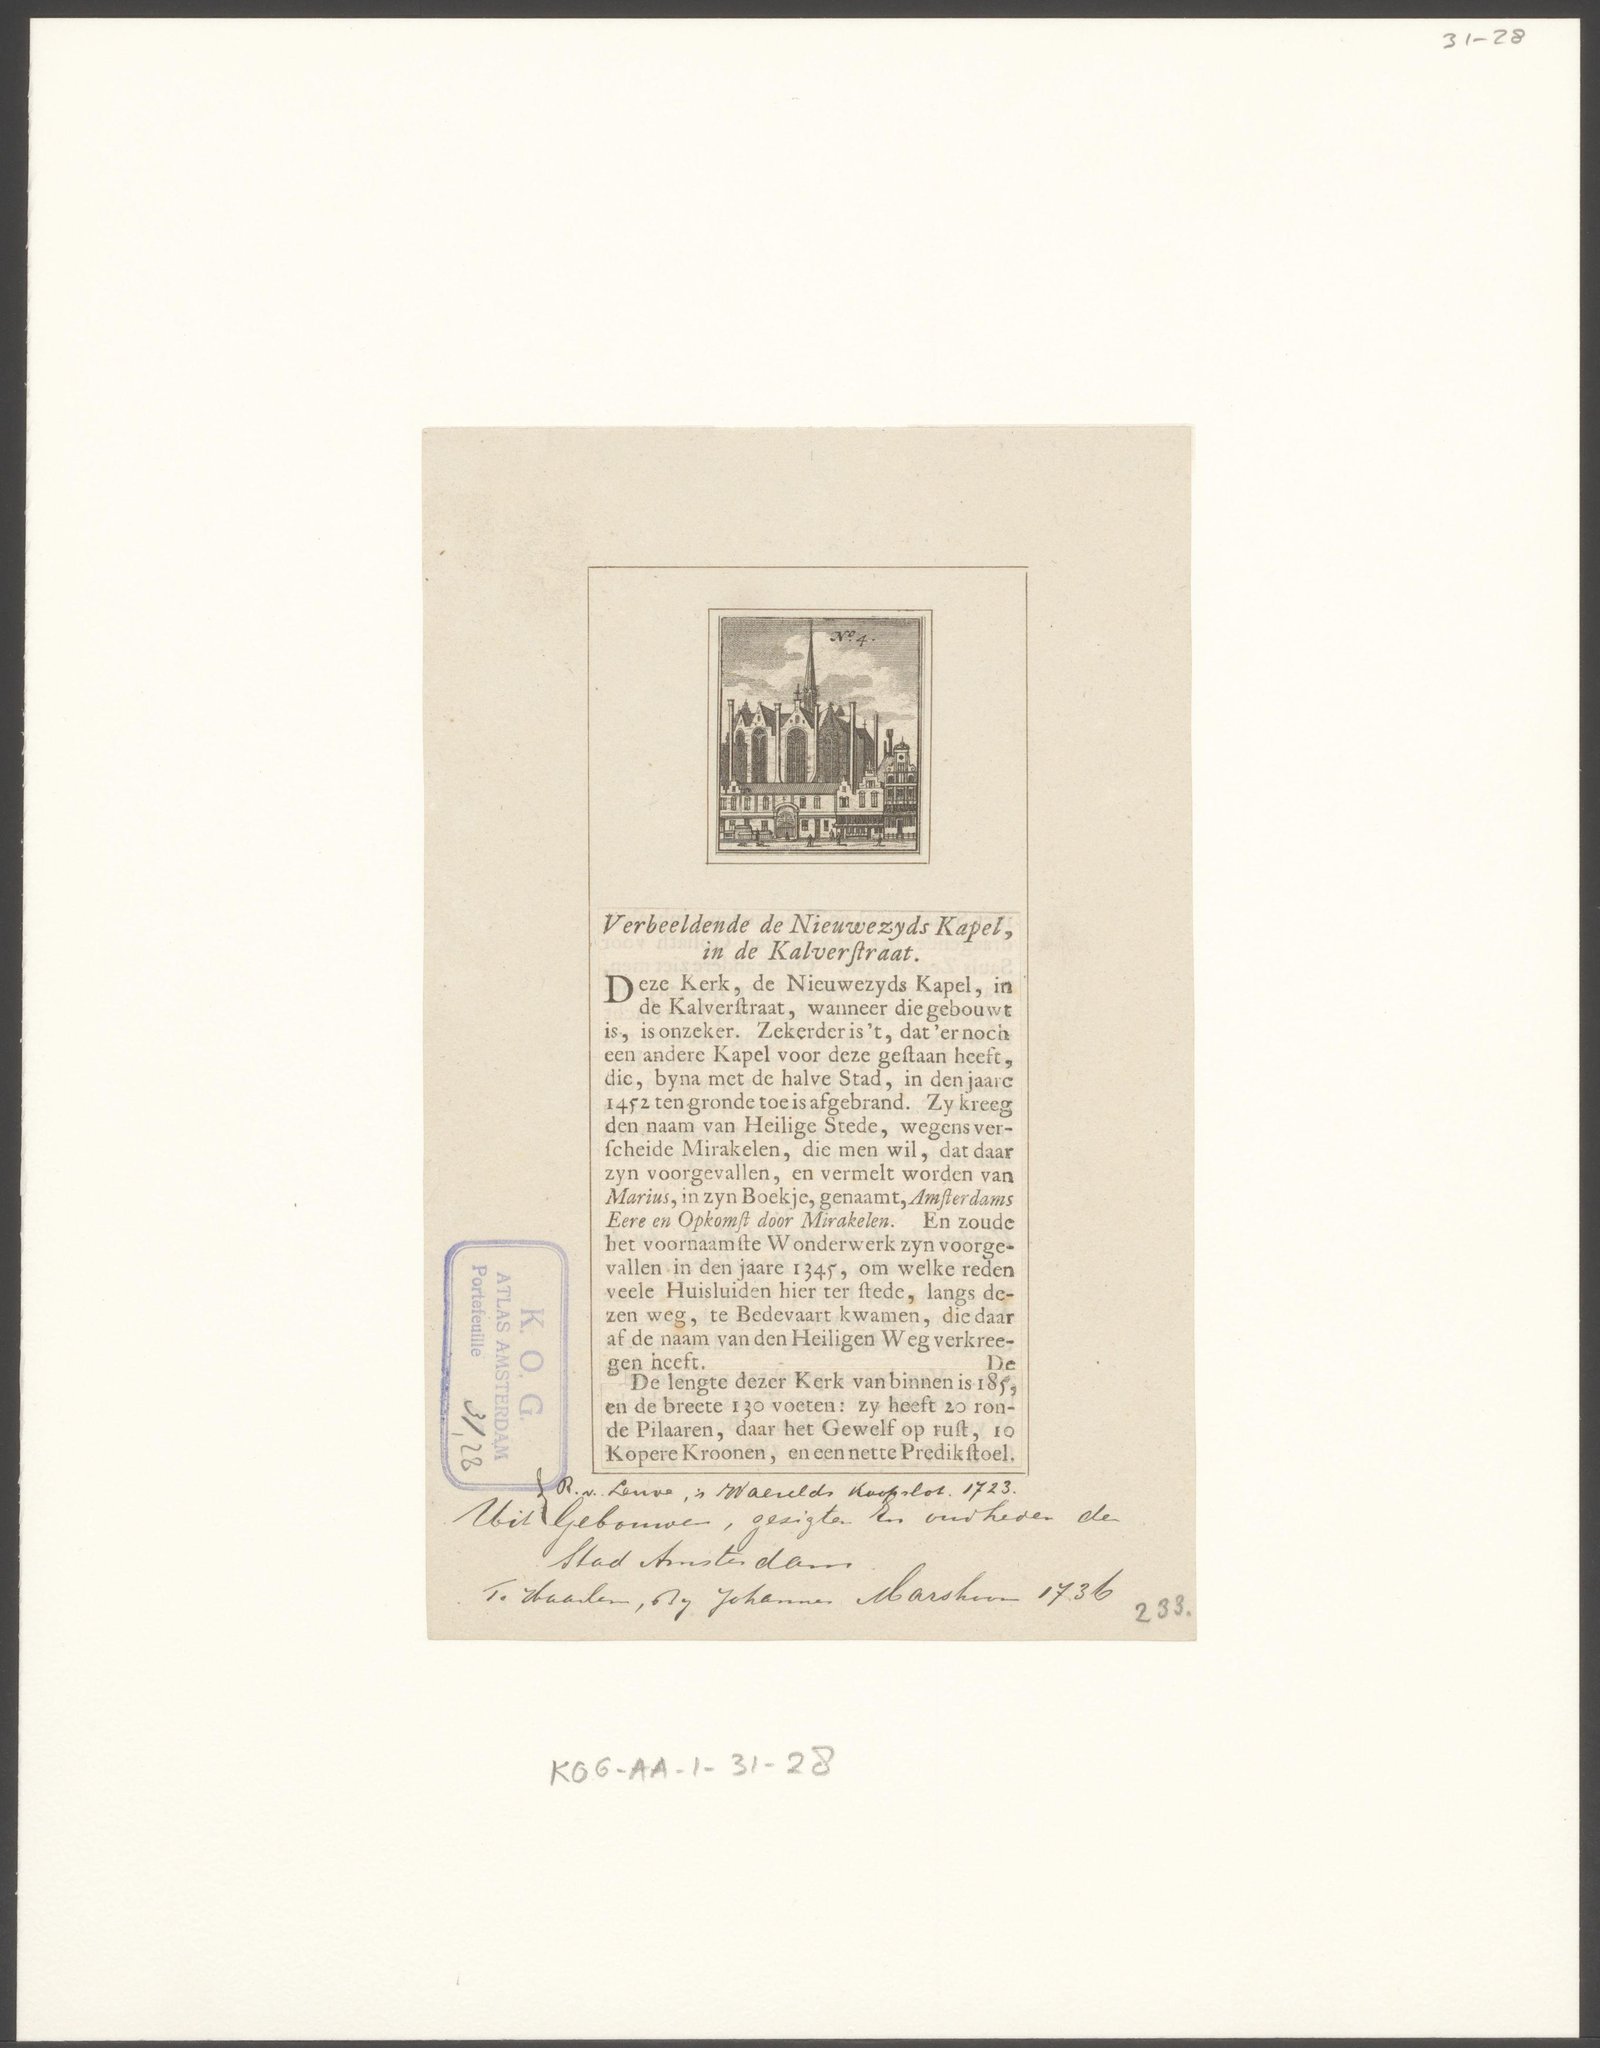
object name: print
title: Gezicht op de Nieuwezijds Kapel te Amsterdam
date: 1736-1744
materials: paper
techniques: etching, letterpress printing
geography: haarlem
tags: church (exterior) - qq - small church, chapel, street (+ city(-scape) with figures, staffage)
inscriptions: collector's mark: Lugt 1641b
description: Centraal bovenaan genummerd: No. 4. Onder de prent is een verklarend bijschrift van de prent geplakt, bestaande uit twee aan elkaar geplakte tekstbladen. Onderwerpsrubriek binnen de Atlas Amsterdam: Kerkwezen: Hervormde Gemeente: Nieuwezijds Kapel.